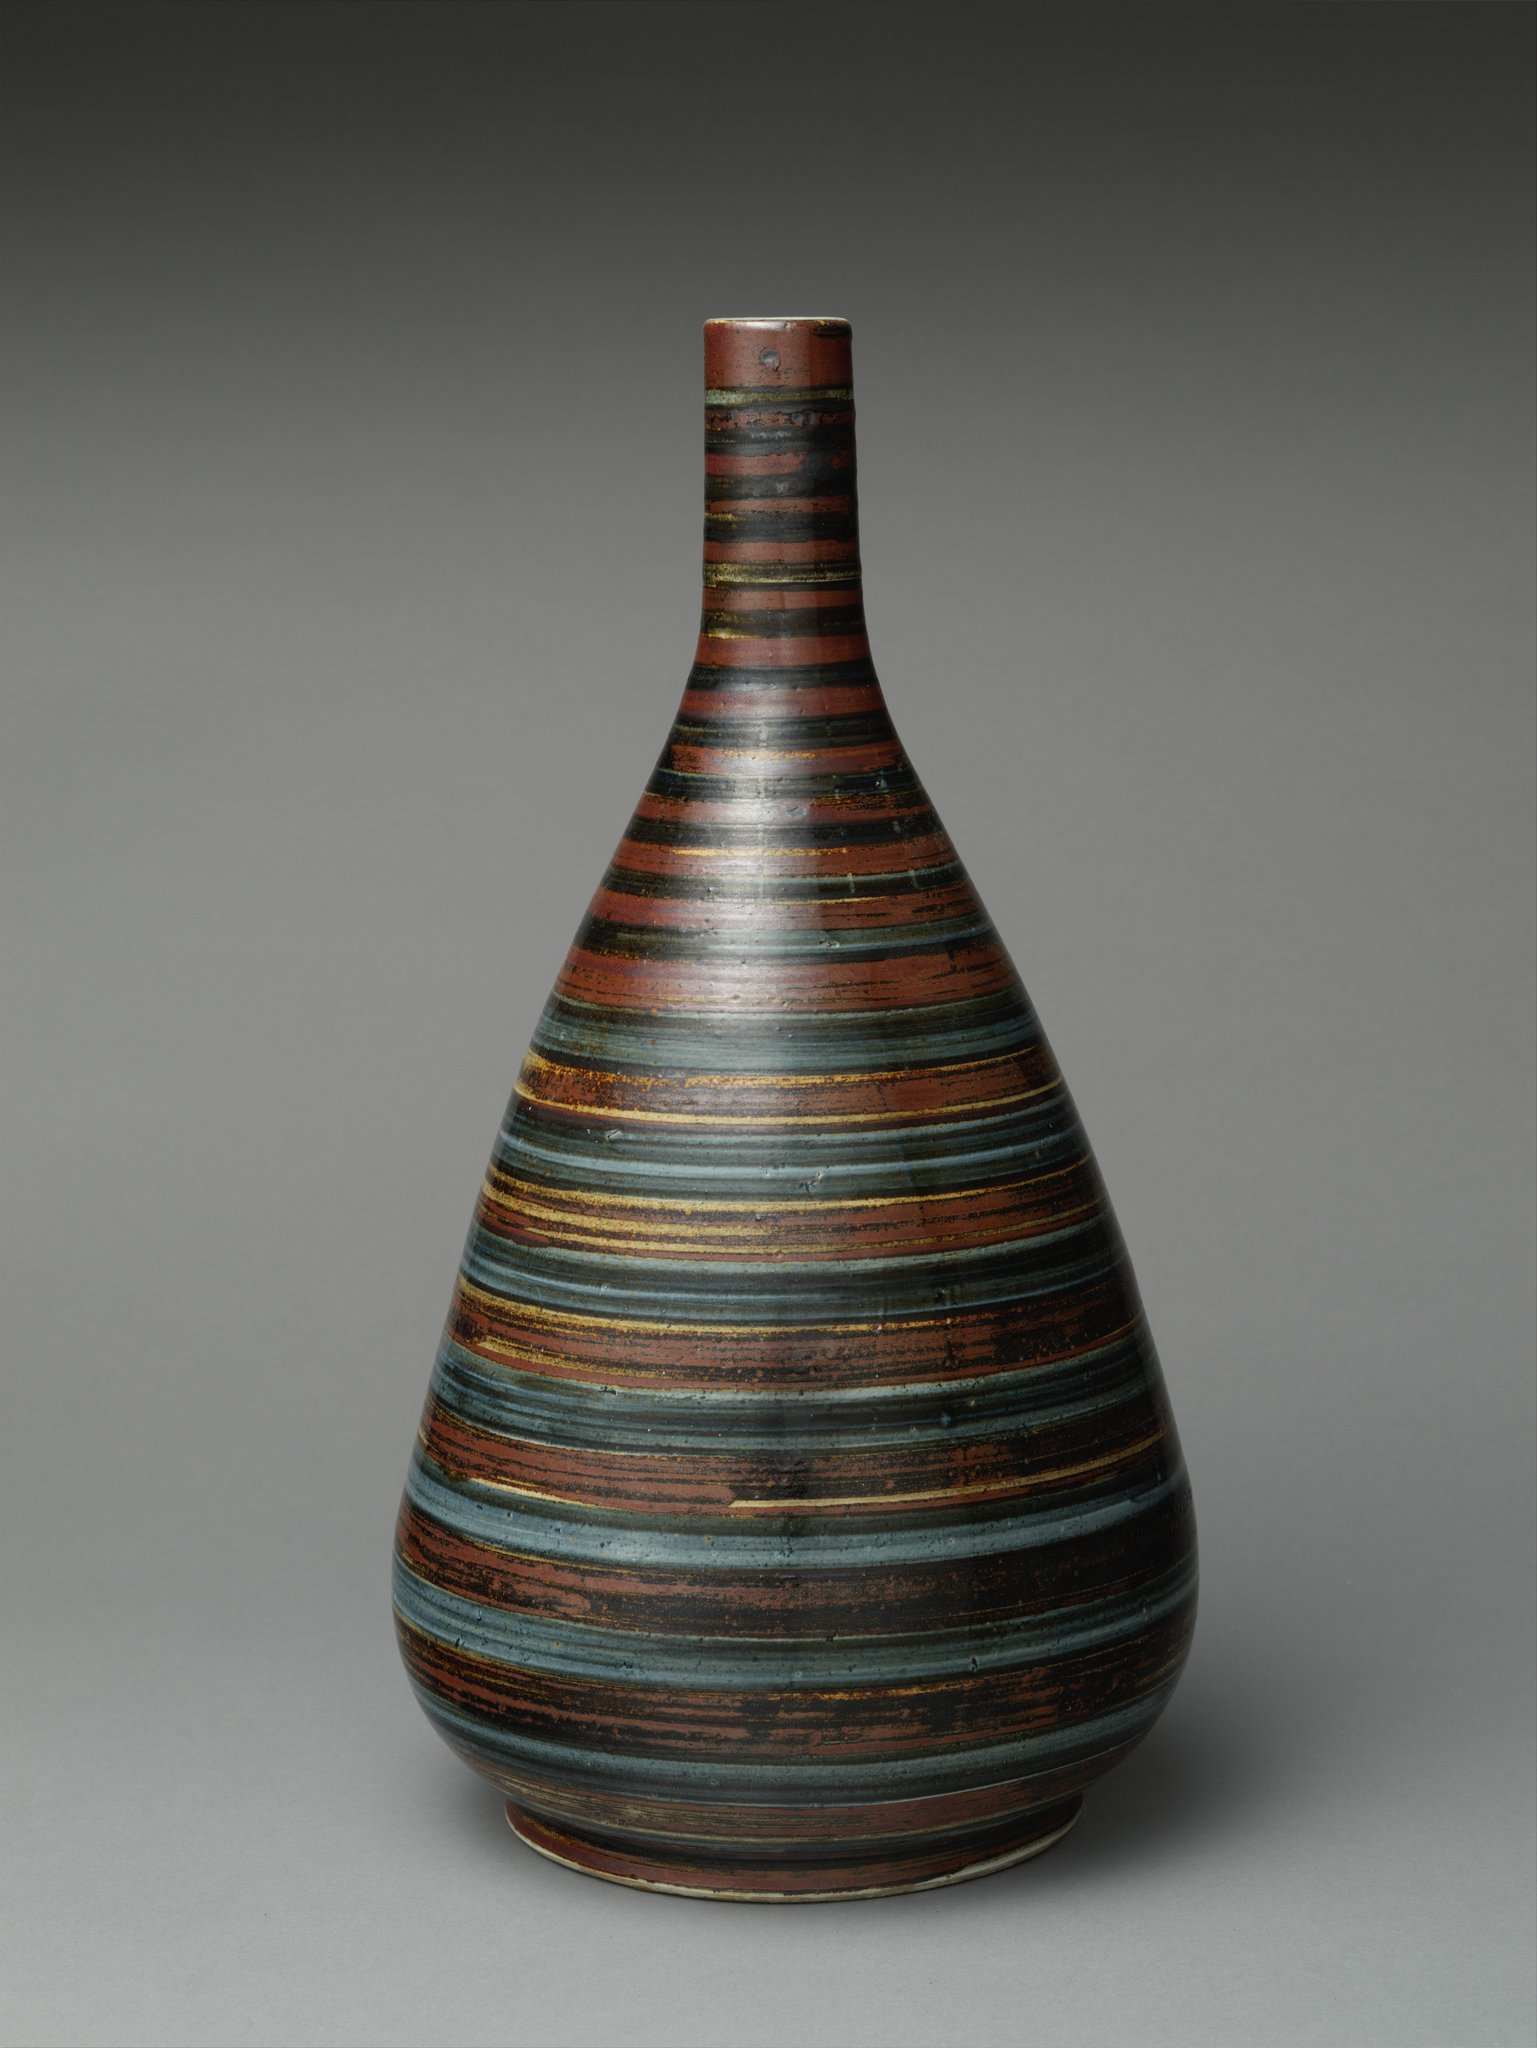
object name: bottle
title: Sake Bottle (Tokkuri)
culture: japanese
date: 1801-1850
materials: iron, porcelain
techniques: underglaze